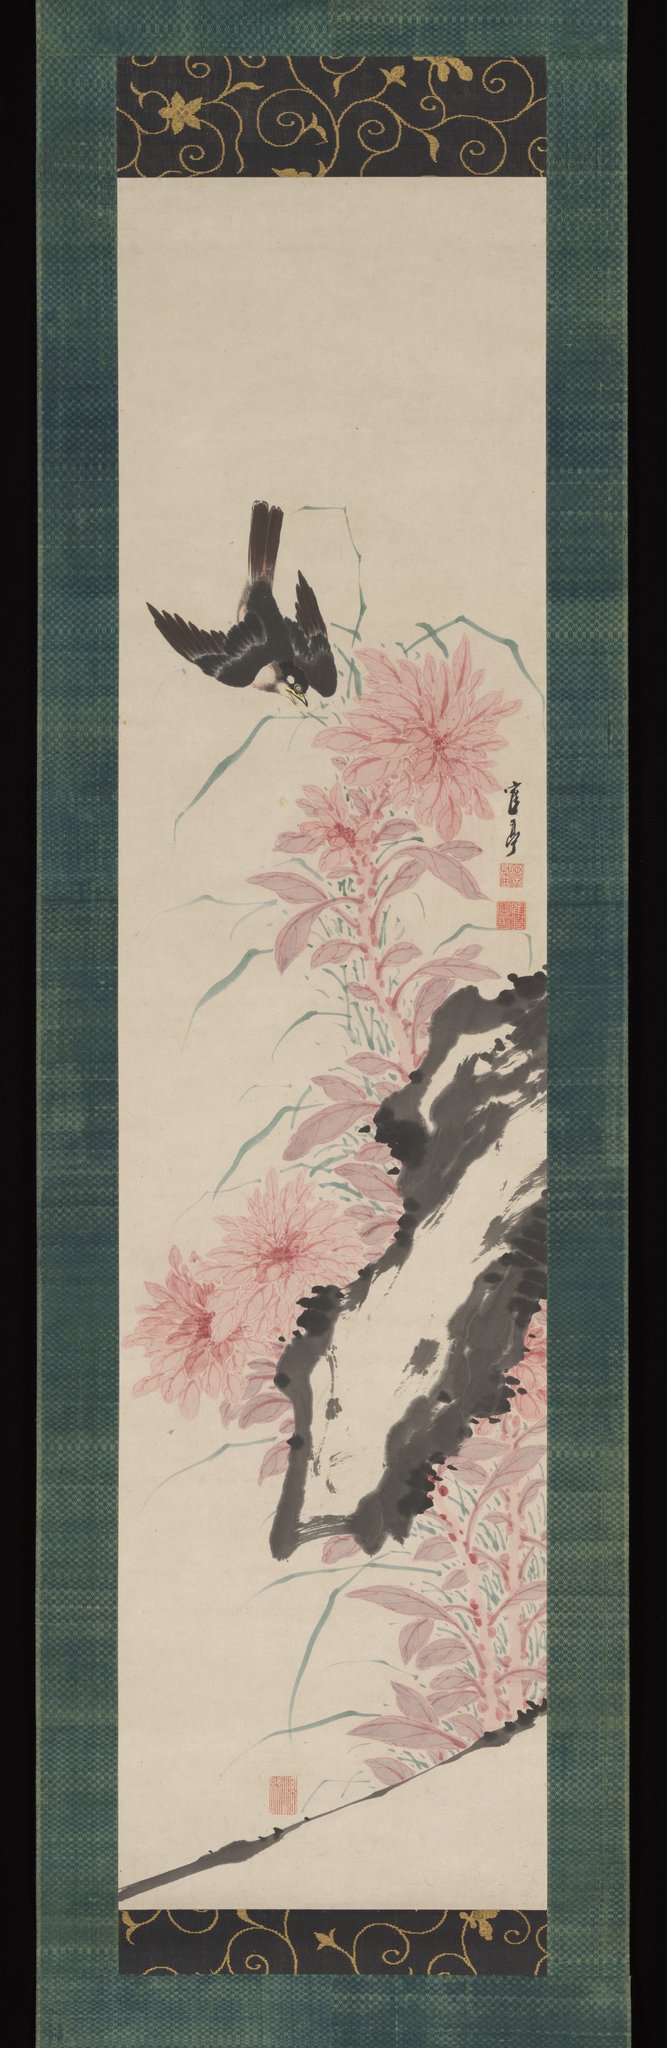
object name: hanging scroll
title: Amaranthus and Mynah Bird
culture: japanese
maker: kakutei (kaigan jōkō)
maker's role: artist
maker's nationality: japanese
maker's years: 1722-1785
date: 1722-1785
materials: paper